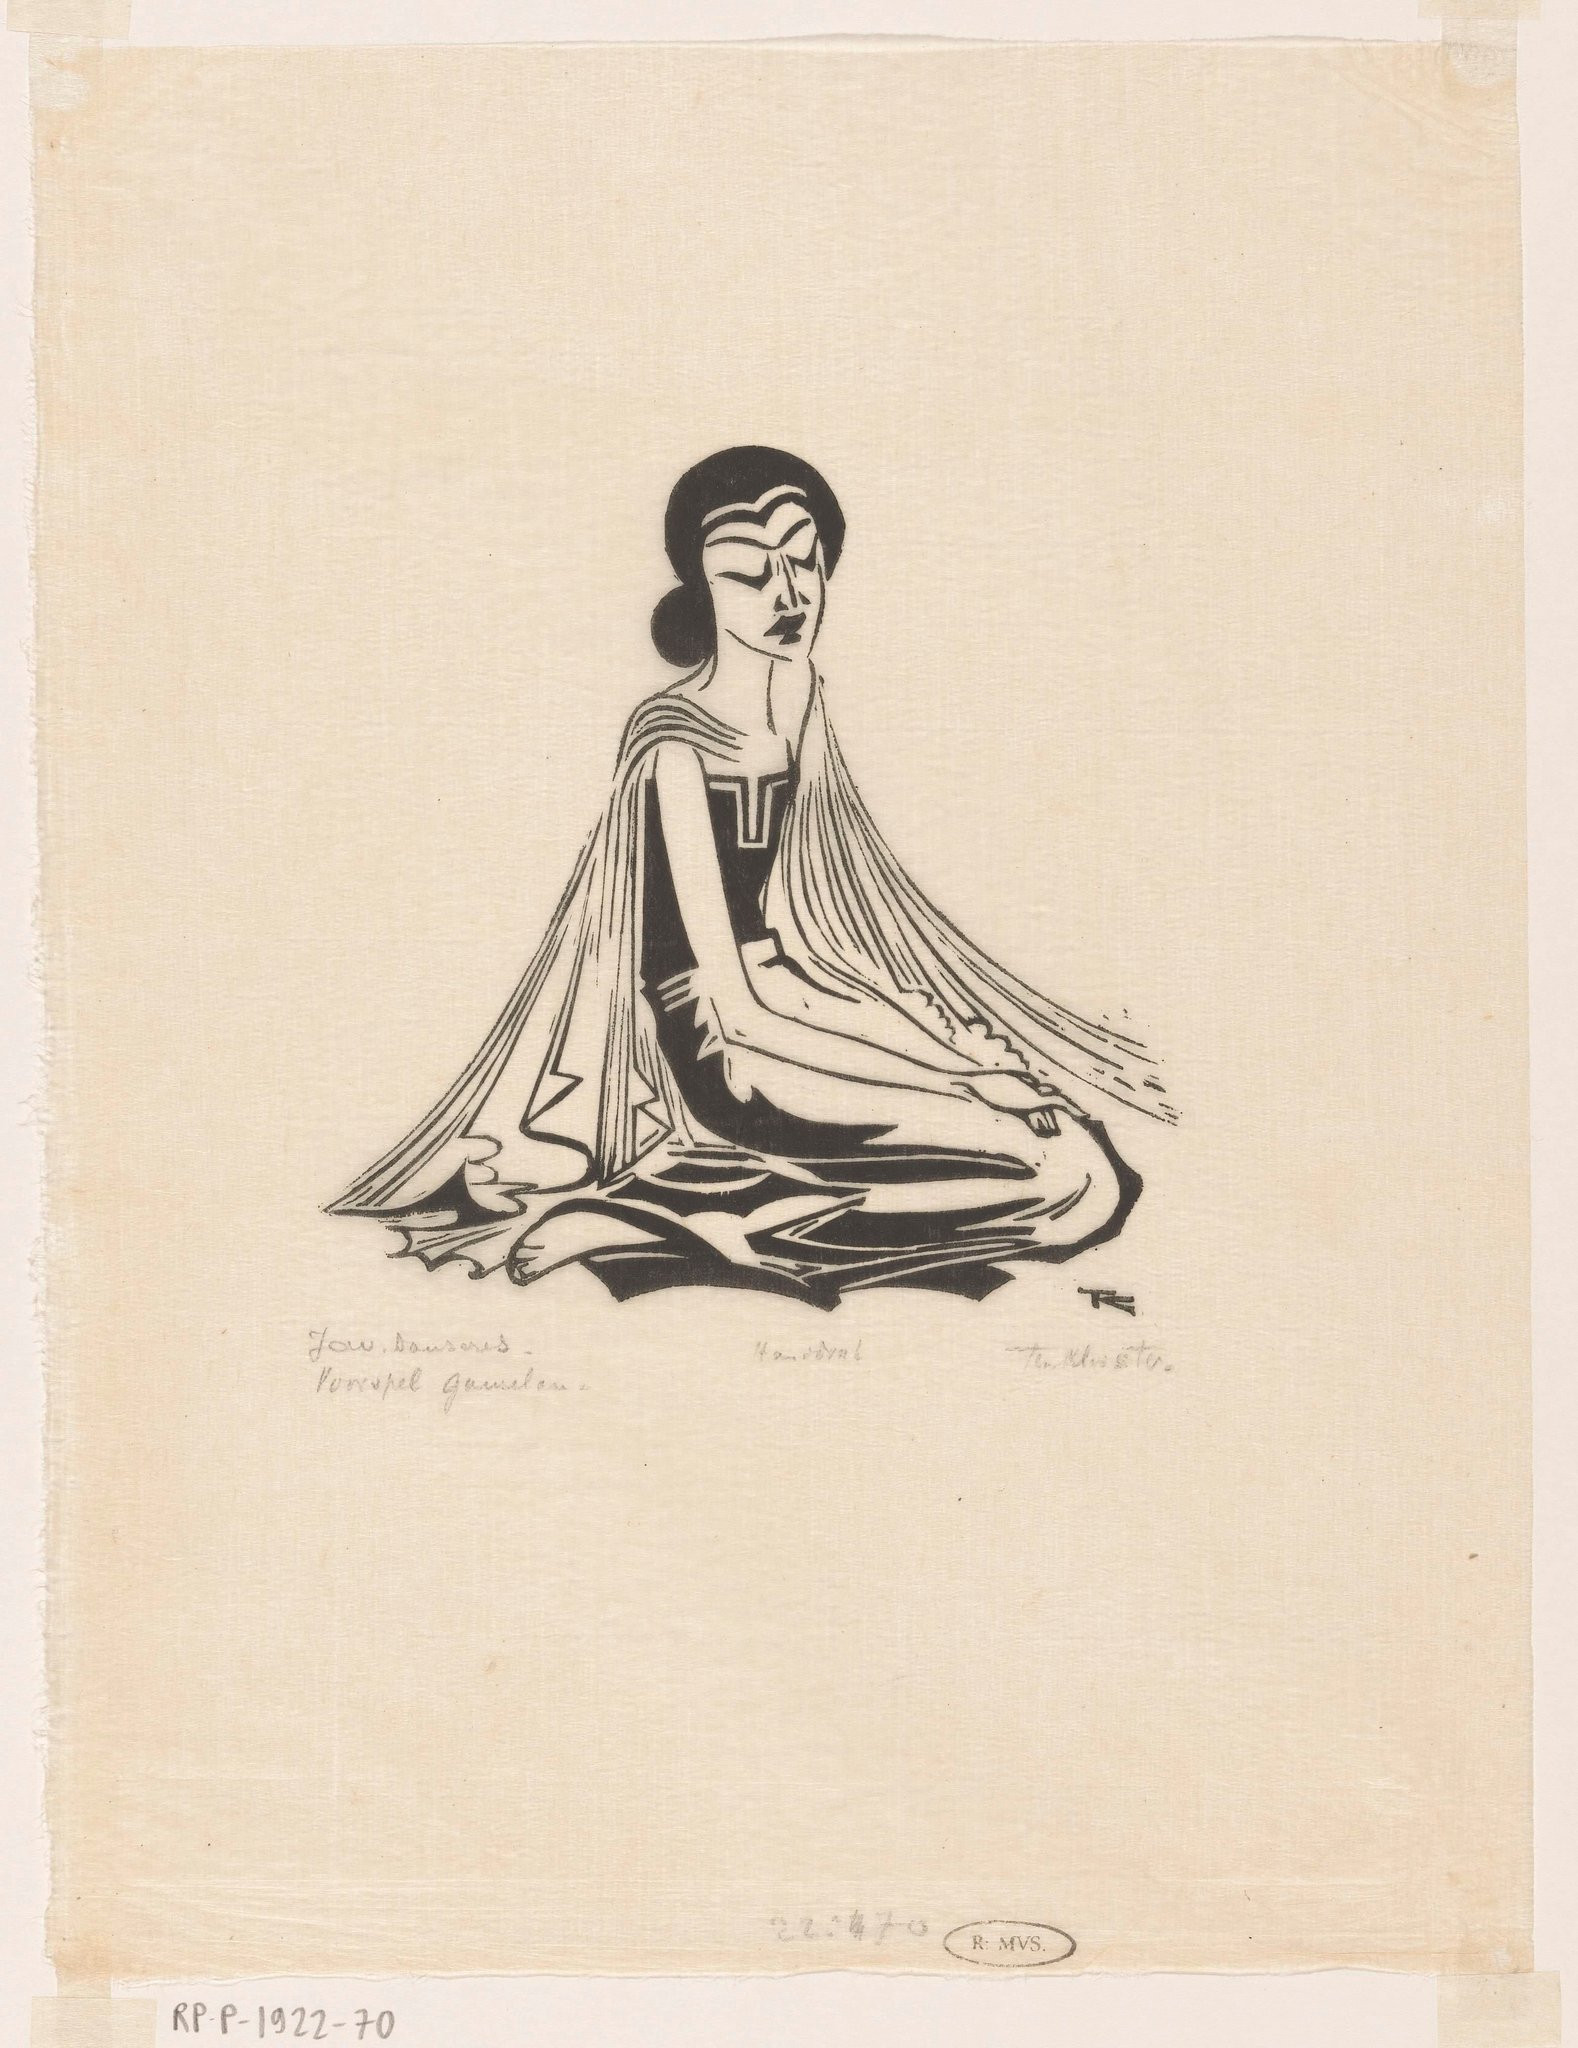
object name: print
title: Voorspel gamelan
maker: johannes frederik engelbert ten klooster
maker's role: draughtsman, print maker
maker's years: 1873-1940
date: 1921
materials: paper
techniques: woodcut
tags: woman dancing alone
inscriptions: collector's mark: Lugt 2228